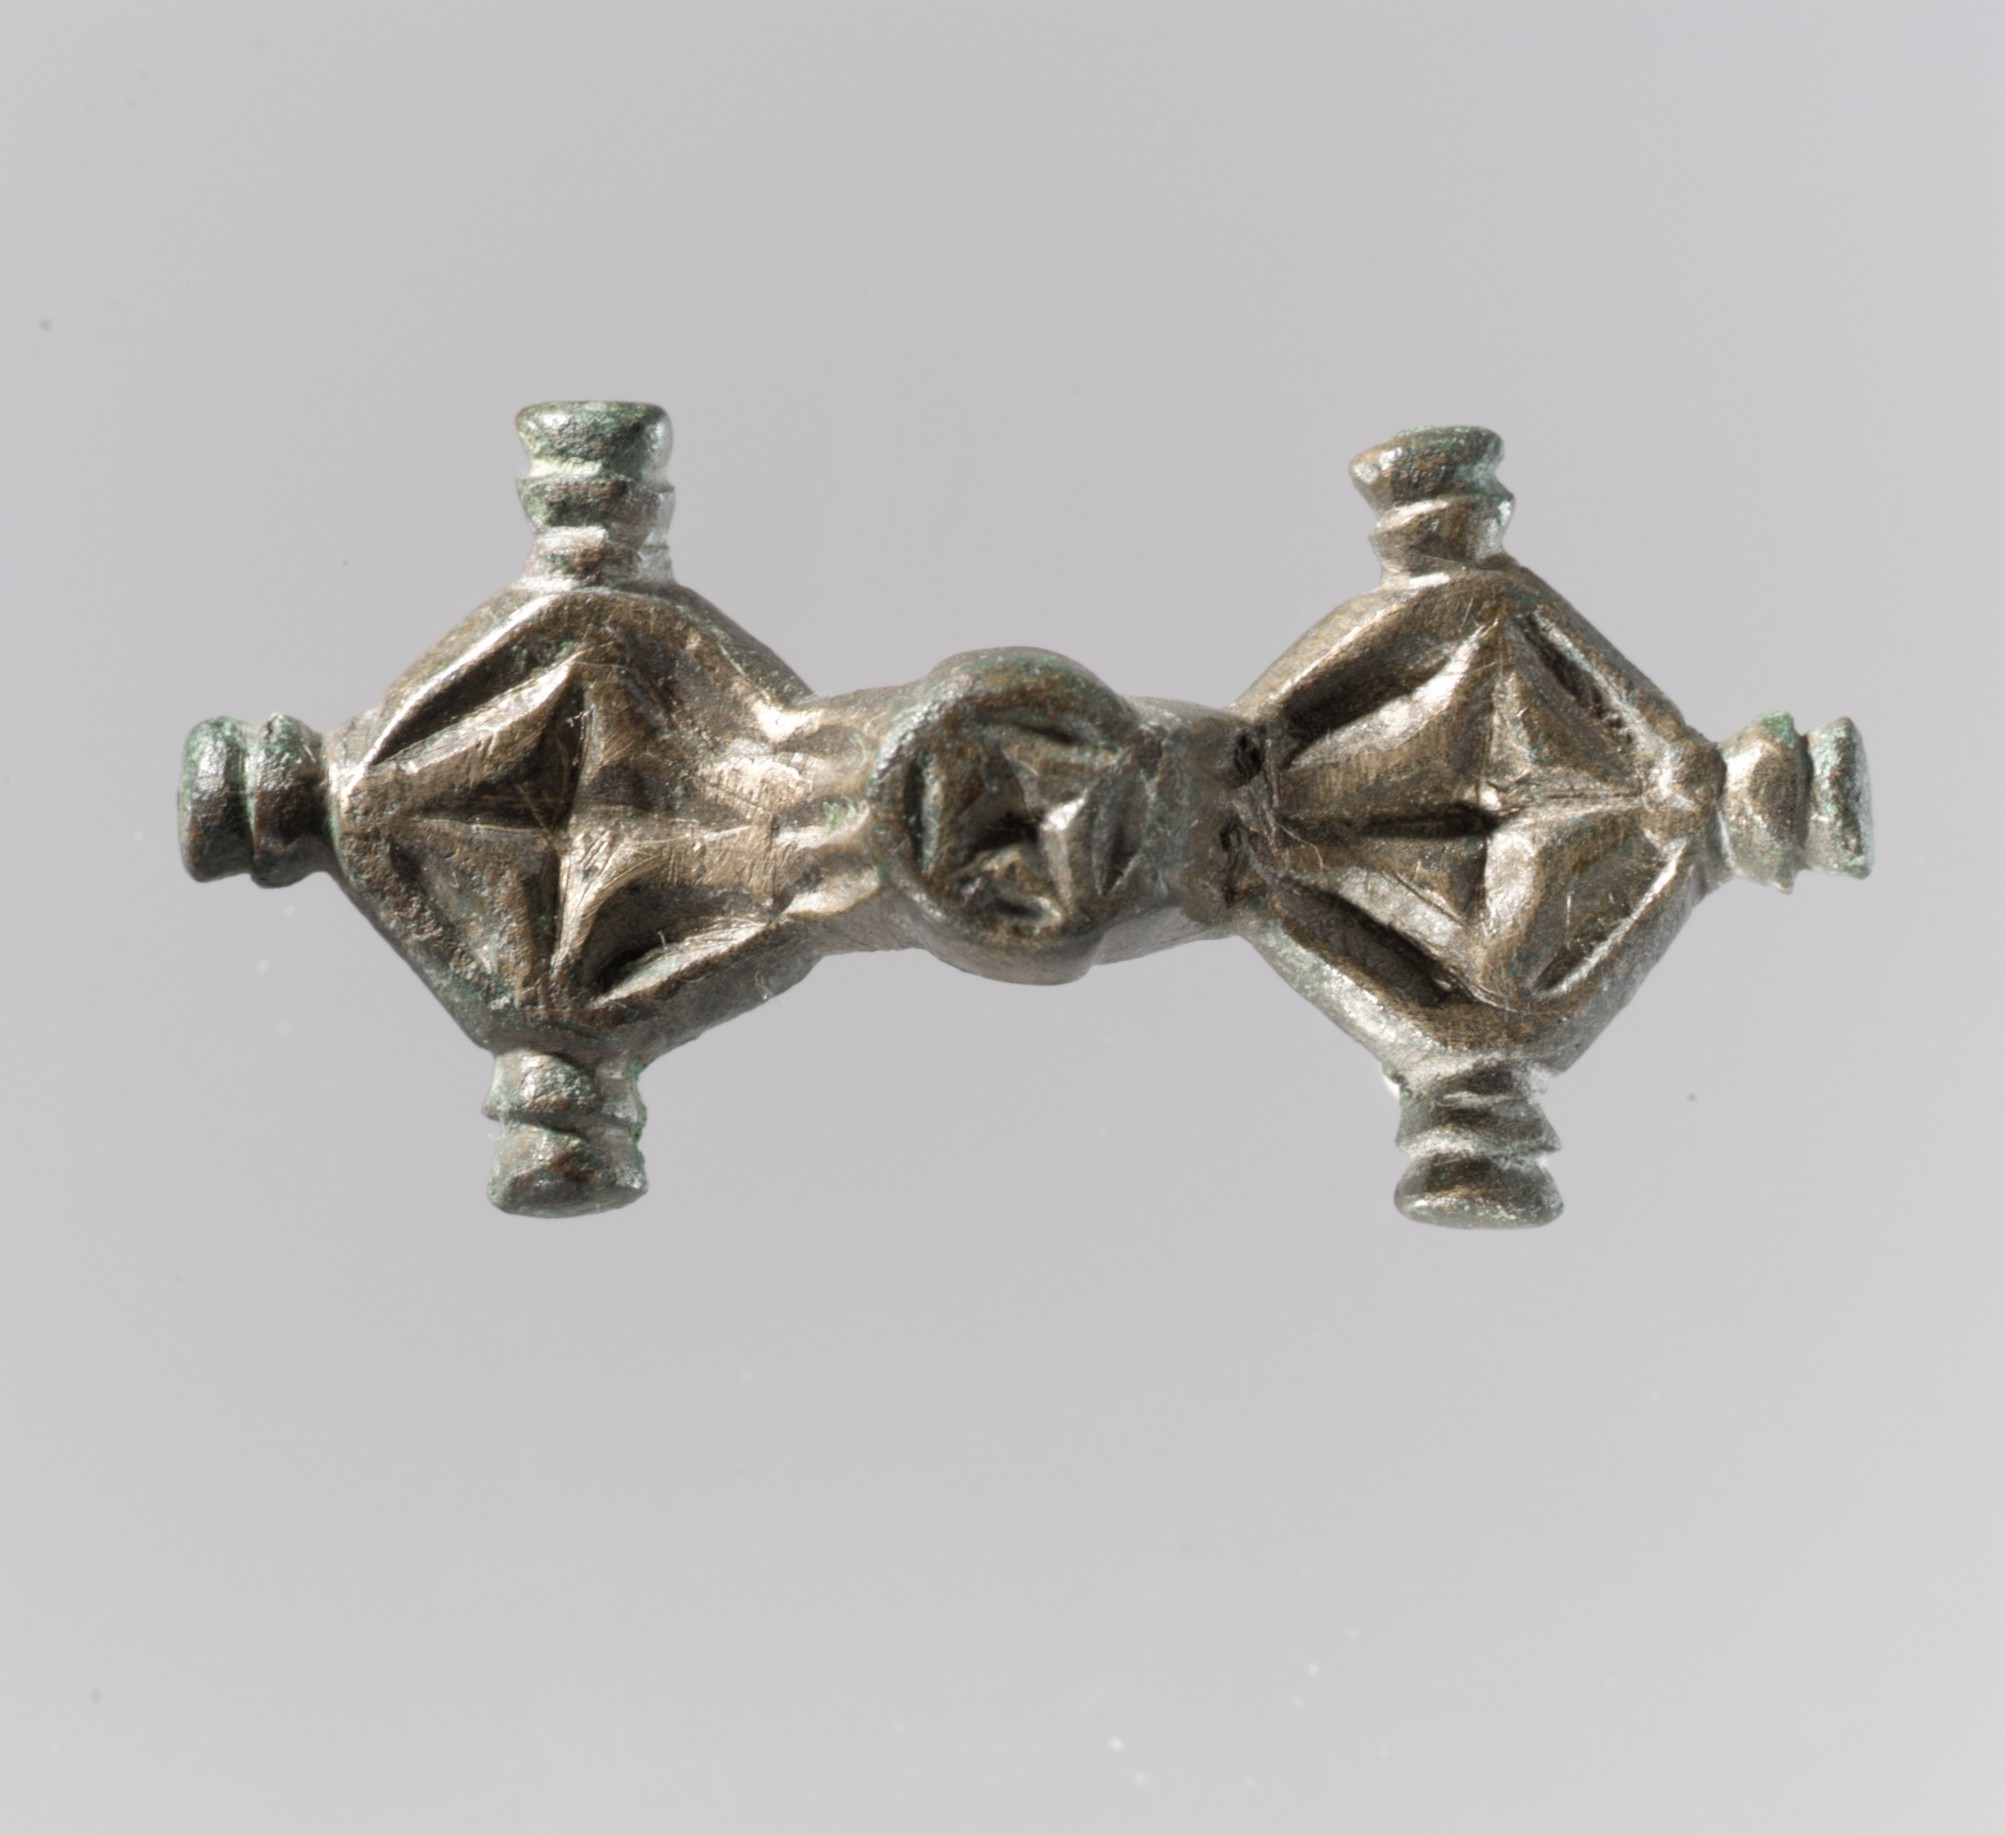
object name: brooch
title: Equal-Arm Brooch with Cross Decoration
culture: frankish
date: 601-800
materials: copper alloy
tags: cross